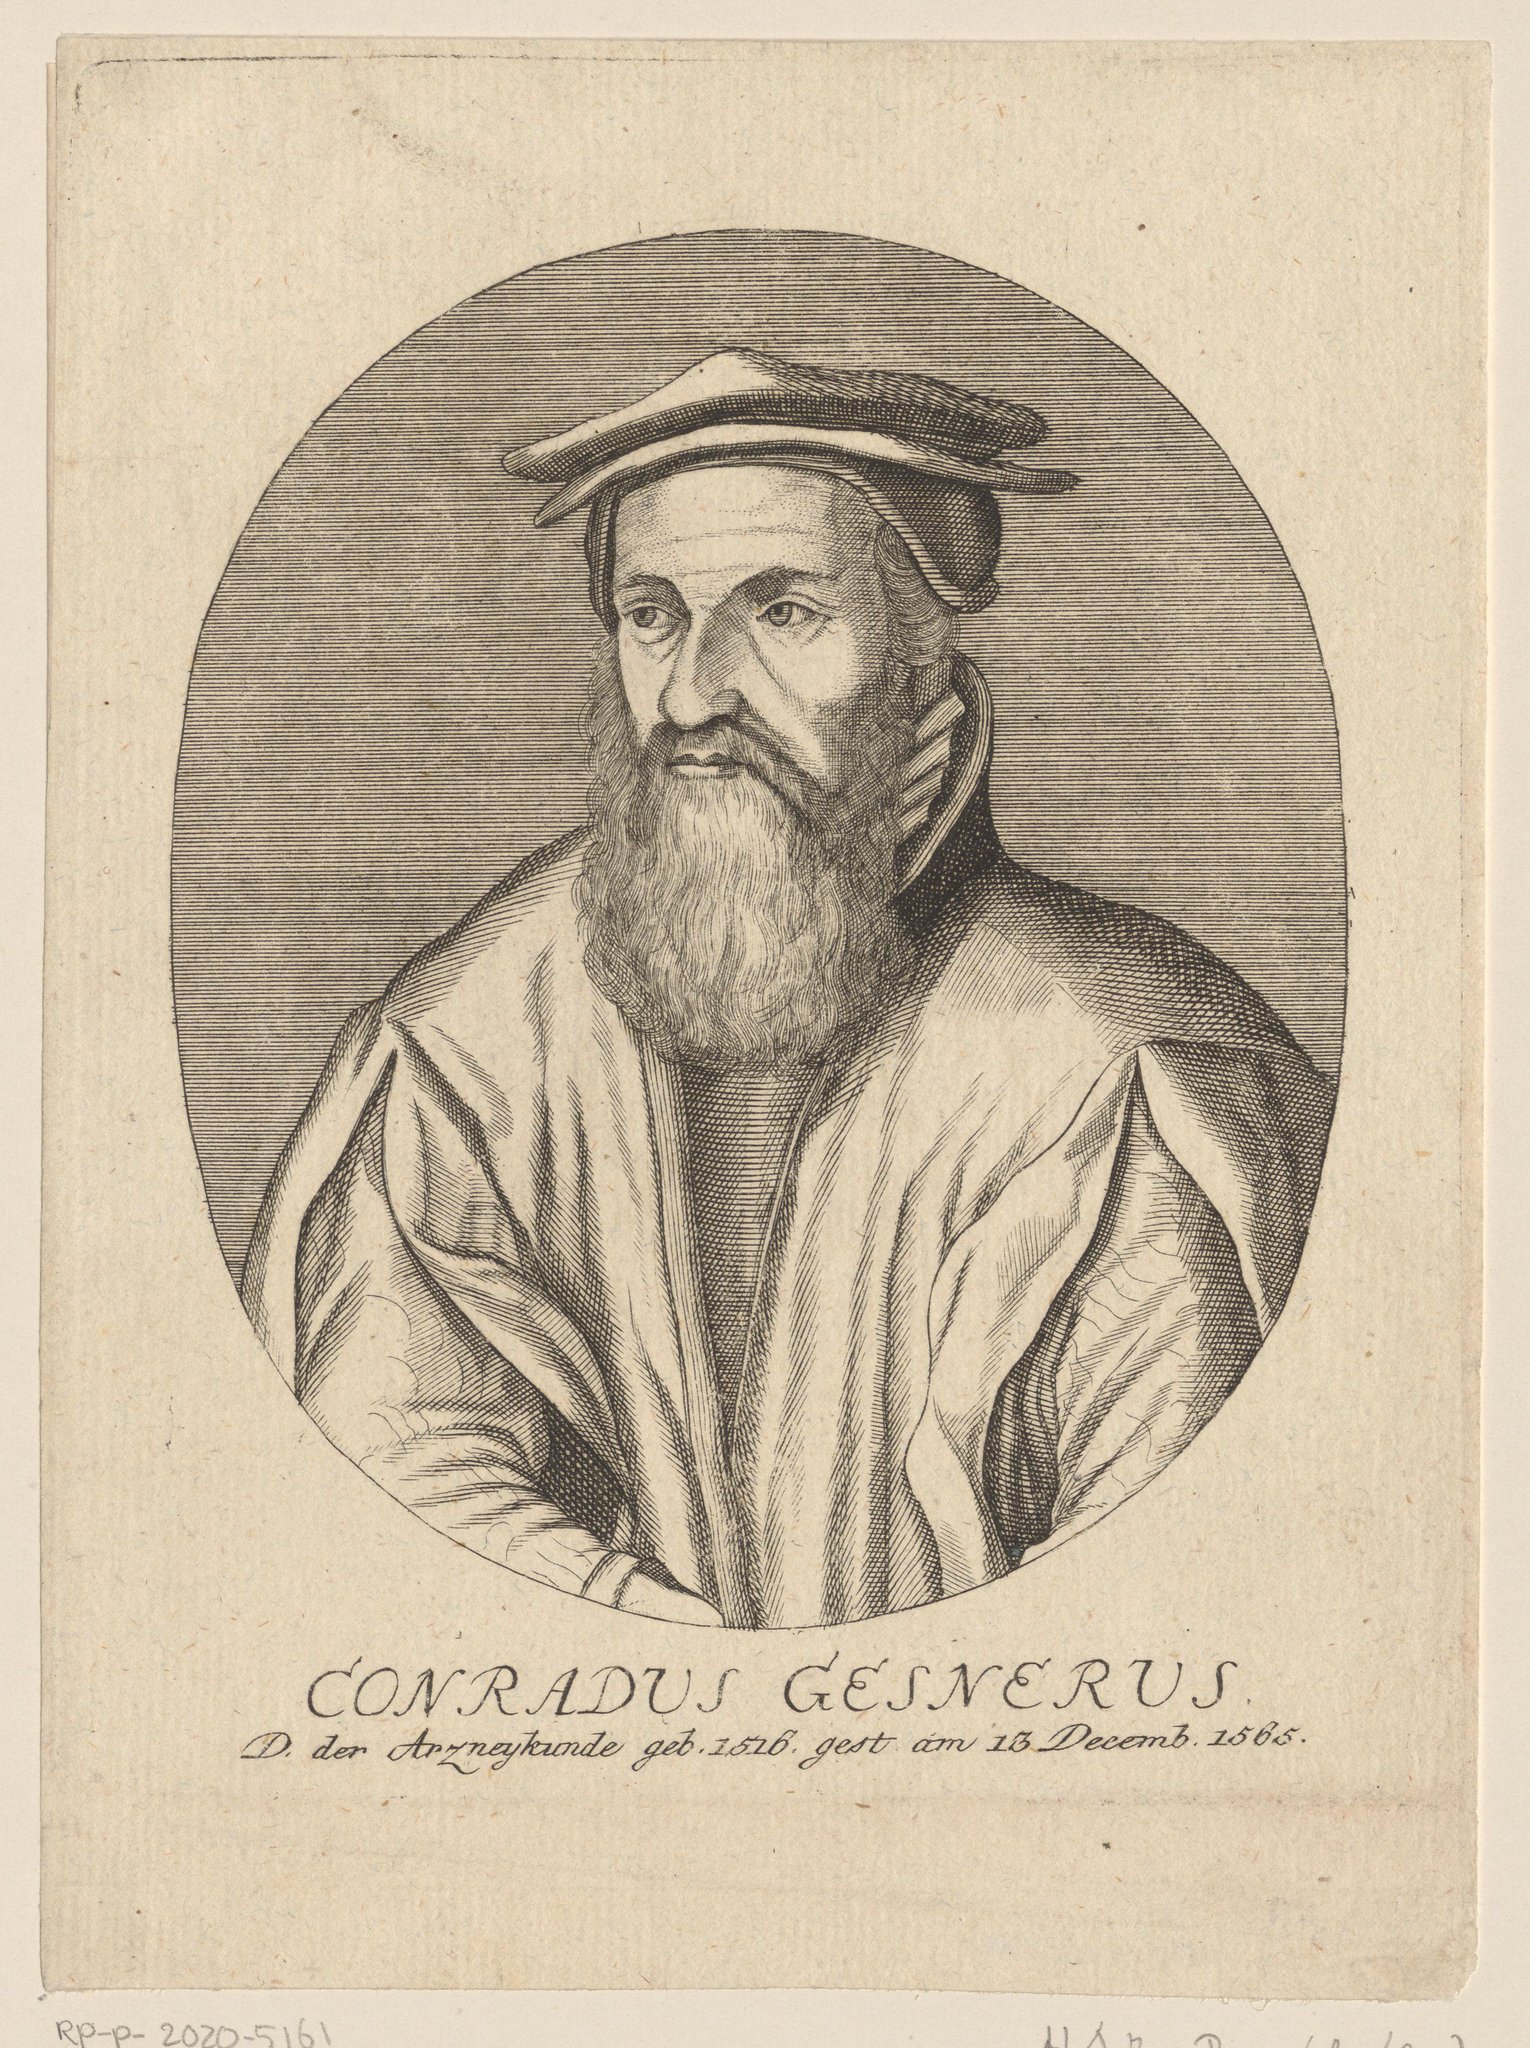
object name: print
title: Portret van Conrad Gesner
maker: Anonymous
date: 1600-1700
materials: paper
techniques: engraving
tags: physicist, theologian, historical persons